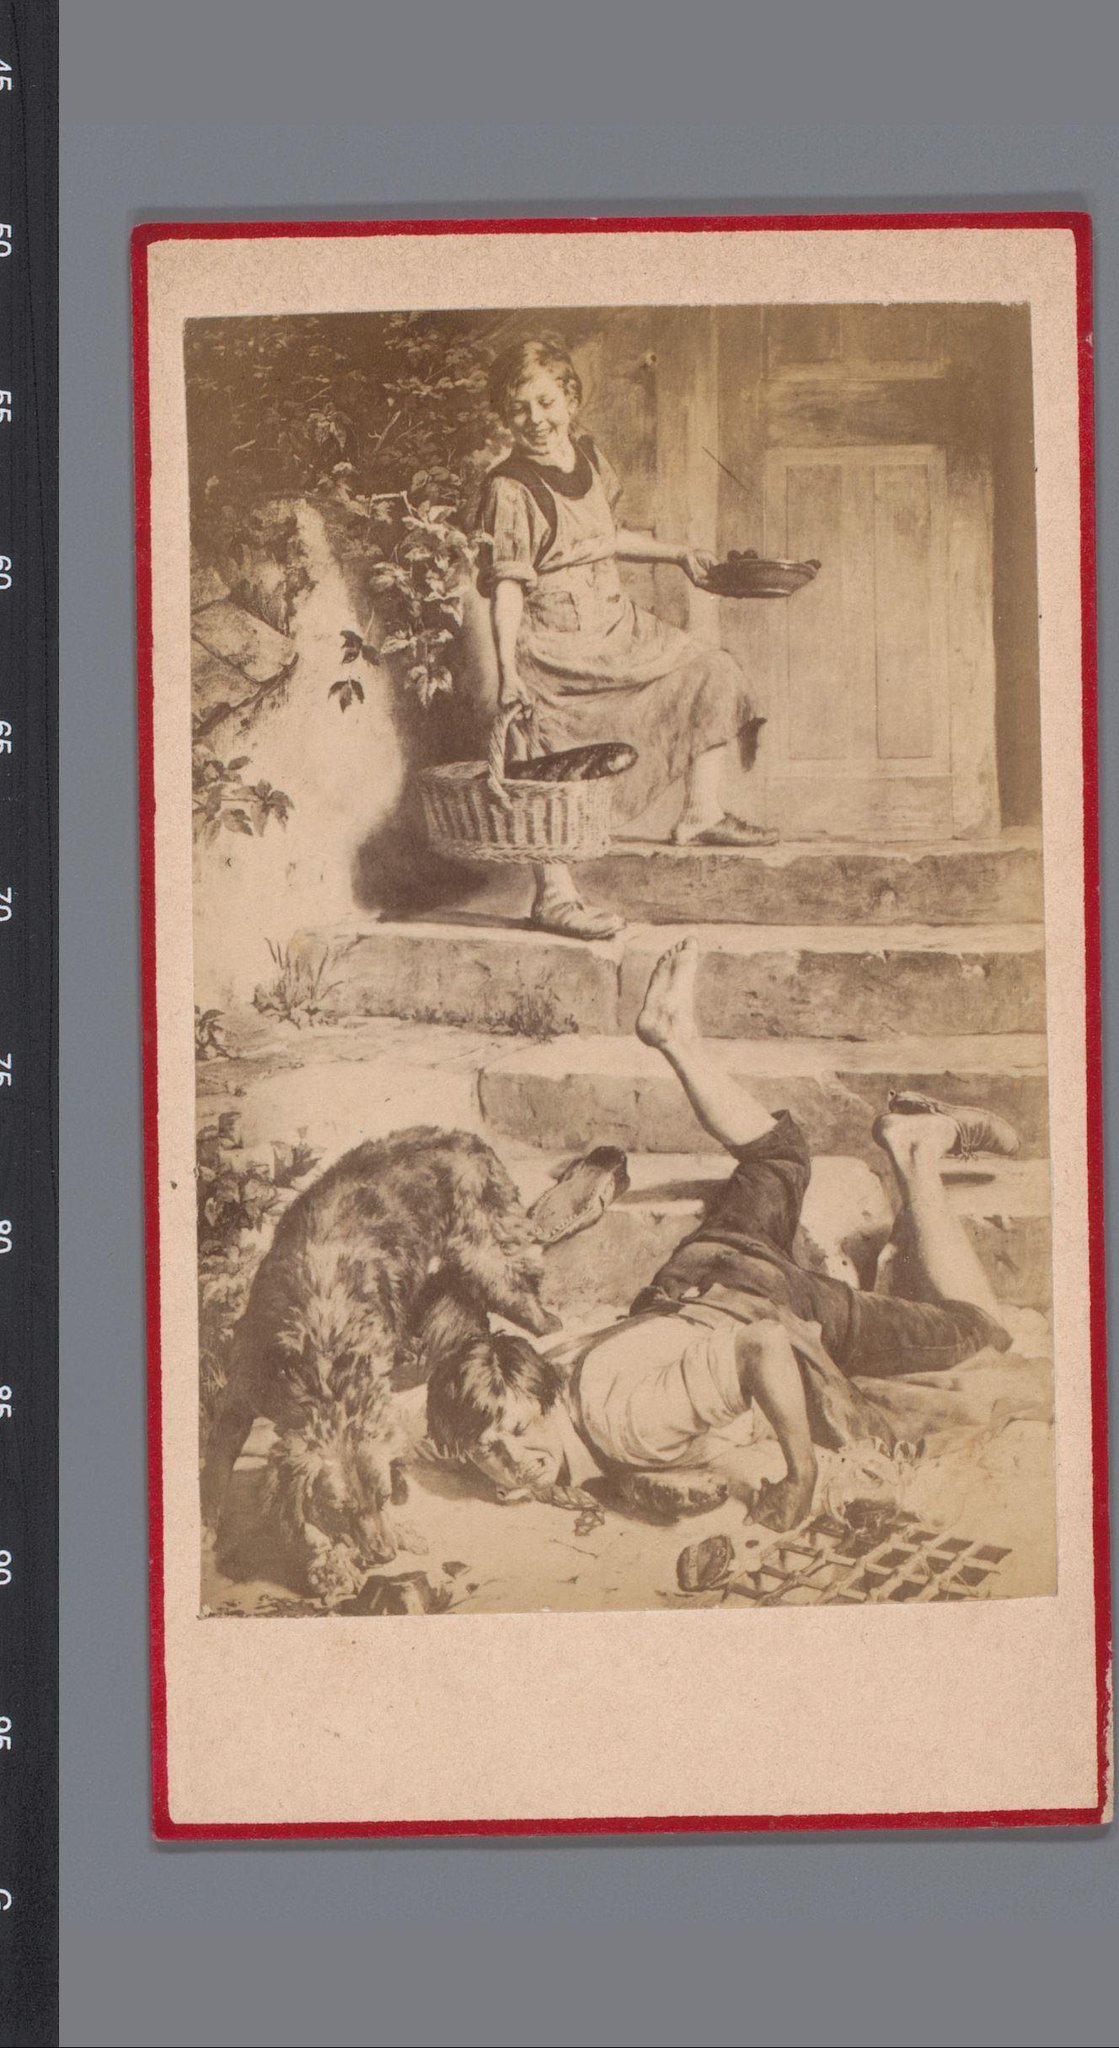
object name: reproduction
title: Fotoreproductie van het schilderij Lacht am besten van Toby Edward Rosenthal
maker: Anonymous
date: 1875-1900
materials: cardboard, paper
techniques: albumen print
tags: boy (child between toddler and youth), laughing, falling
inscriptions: number: ‘408’, inscription: ‘T. Rosenthal.’